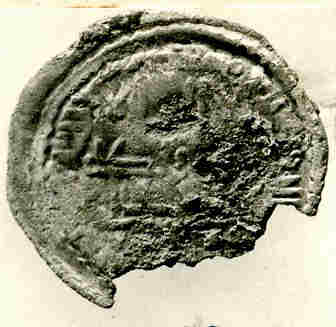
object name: coin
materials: copper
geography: iran